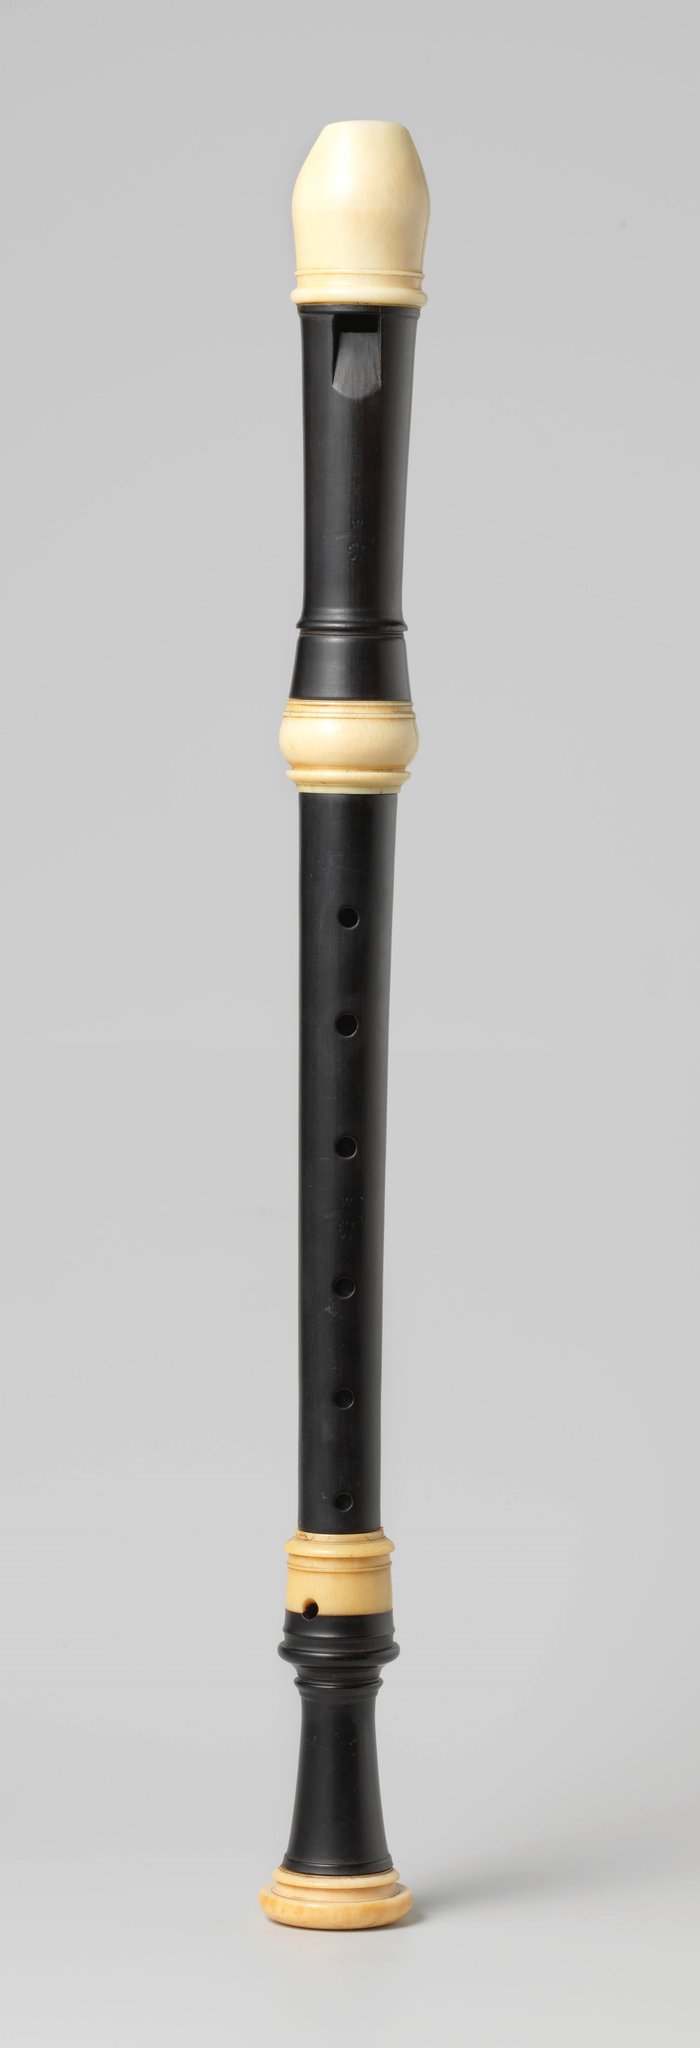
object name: flute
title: Alto recorder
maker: thomas coenrat boekhout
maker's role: musical instrument maker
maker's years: 1666-1715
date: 1700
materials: wood, ivory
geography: amsterdam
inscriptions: mark, on the head, main and foot joint, stamped: ‘T.BOEKHOUT’ [crown]/ T.BOEKHOUT/ [a lion rampant]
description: Altblokfluit, gemerkt met ivoor, gemerkt: T. Boekhout.